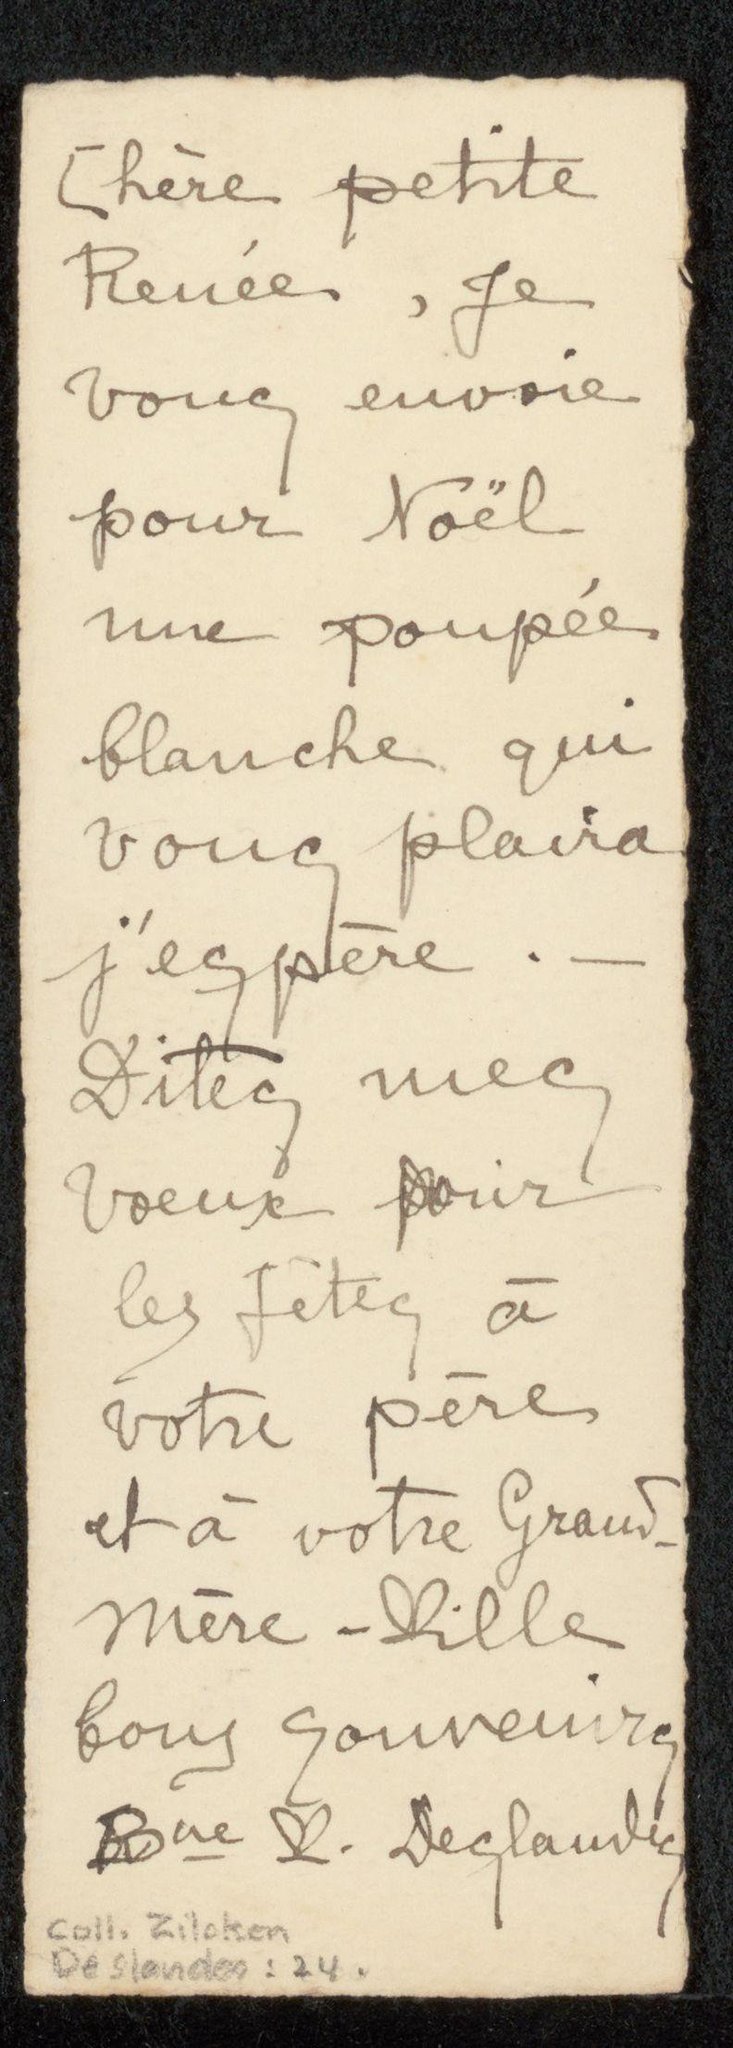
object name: christmas card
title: Kerstkaart aan Renée Hélène Laure Zilcken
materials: ink, paper, watercolor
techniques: brush, pen, writing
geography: paris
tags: voorburg, print maker, renée hélène laure zilcken, the hague, painter, draughtsman, philip zilcken, water-birds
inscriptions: collector's mark: ‘RPK’, monogram: ‘TM’